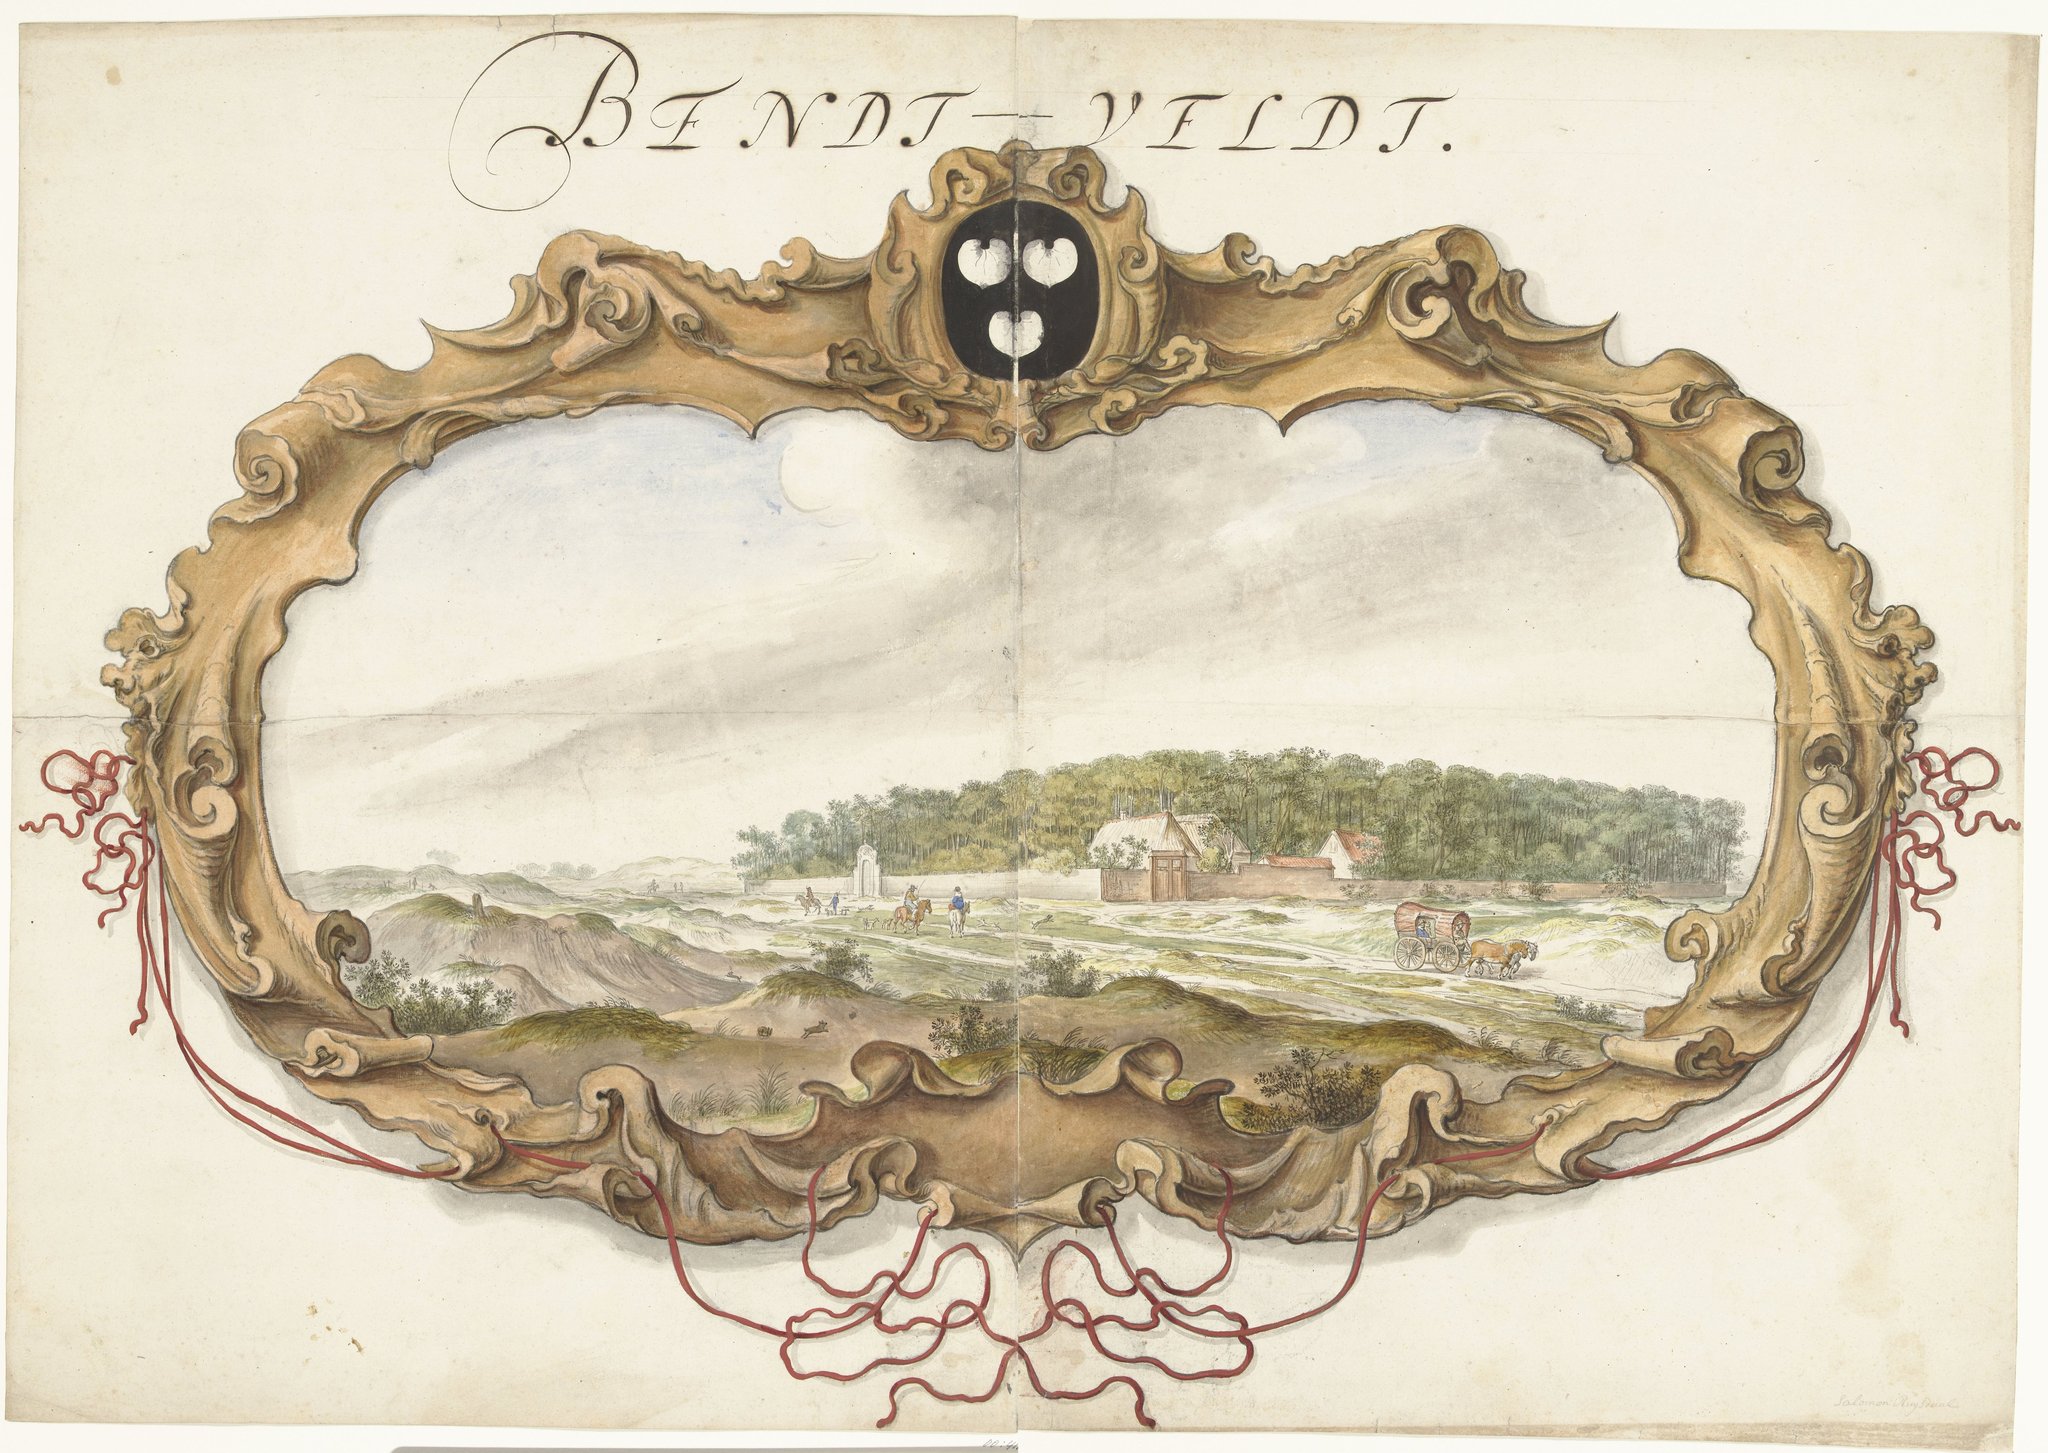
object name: drawing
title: Cartouche met gezicht op het buitengoed Bentveld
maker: Anonymous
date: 1600-1699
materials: chalk, ink, paper, watercolor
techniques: brush, pen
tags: dunes (sea not visible); in the dunes, rural housing, e.g. country-house, villa, cottage, ornament ~ cartouche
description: Voorstelling op twee bladen met een gezicht op Bentveld.